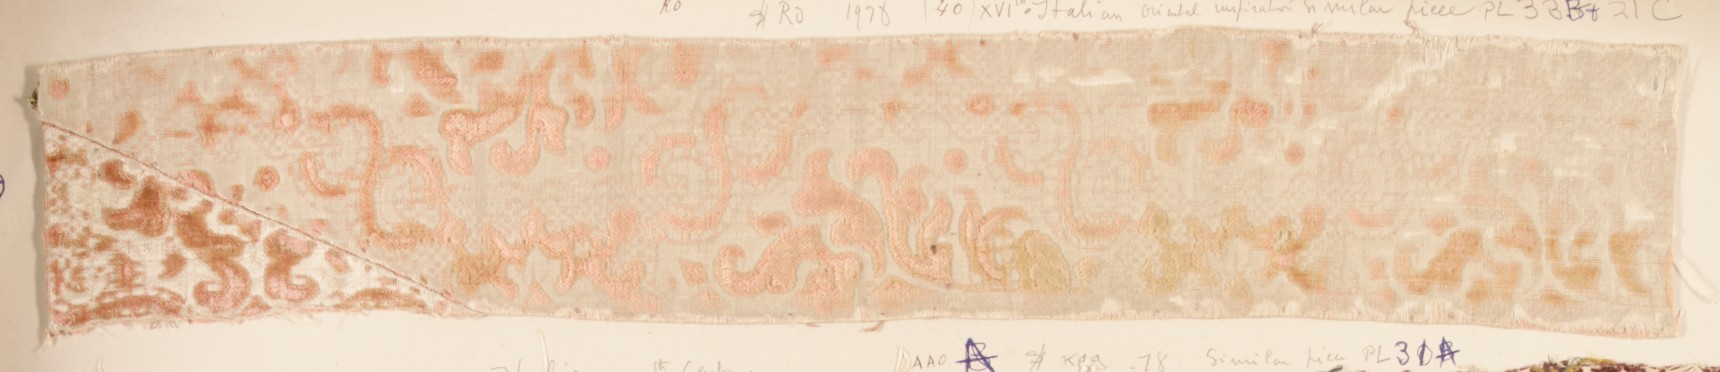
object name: fragment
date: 1501-1600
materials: silk